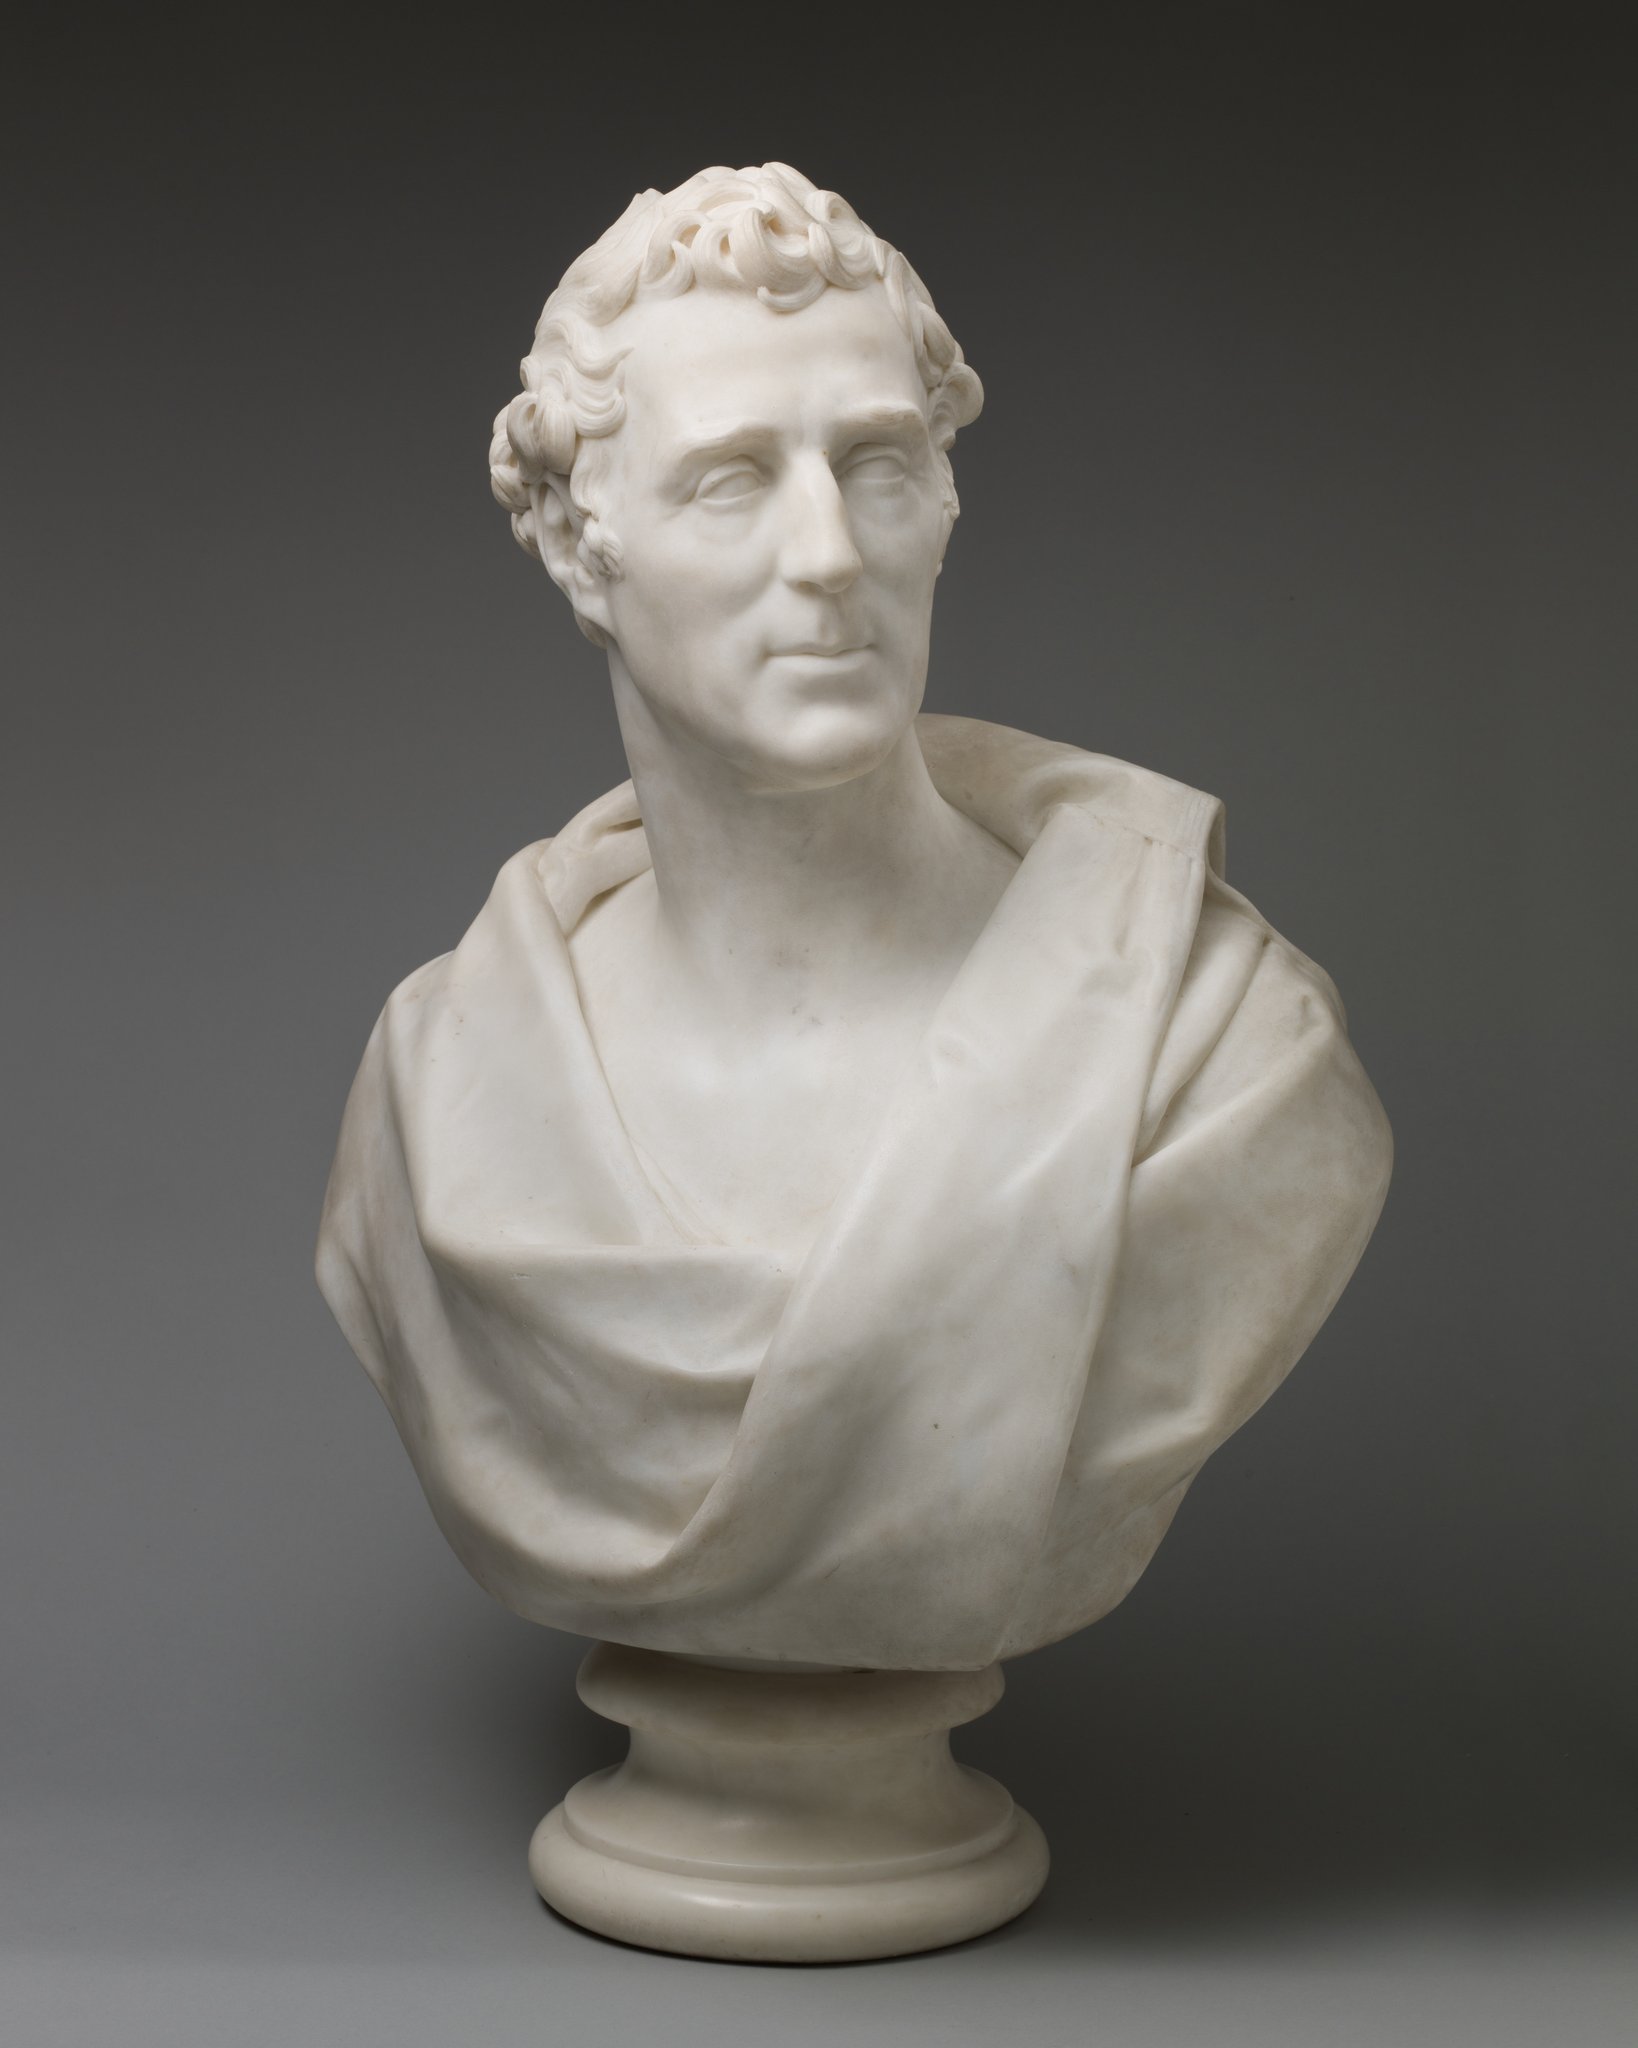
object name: bust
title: Arthur Wellesley, 1st Duke of Wellington (1769–1852)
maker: sir francis chantrey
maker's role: artist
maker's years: 1781-1841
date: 1823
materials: marble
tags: men